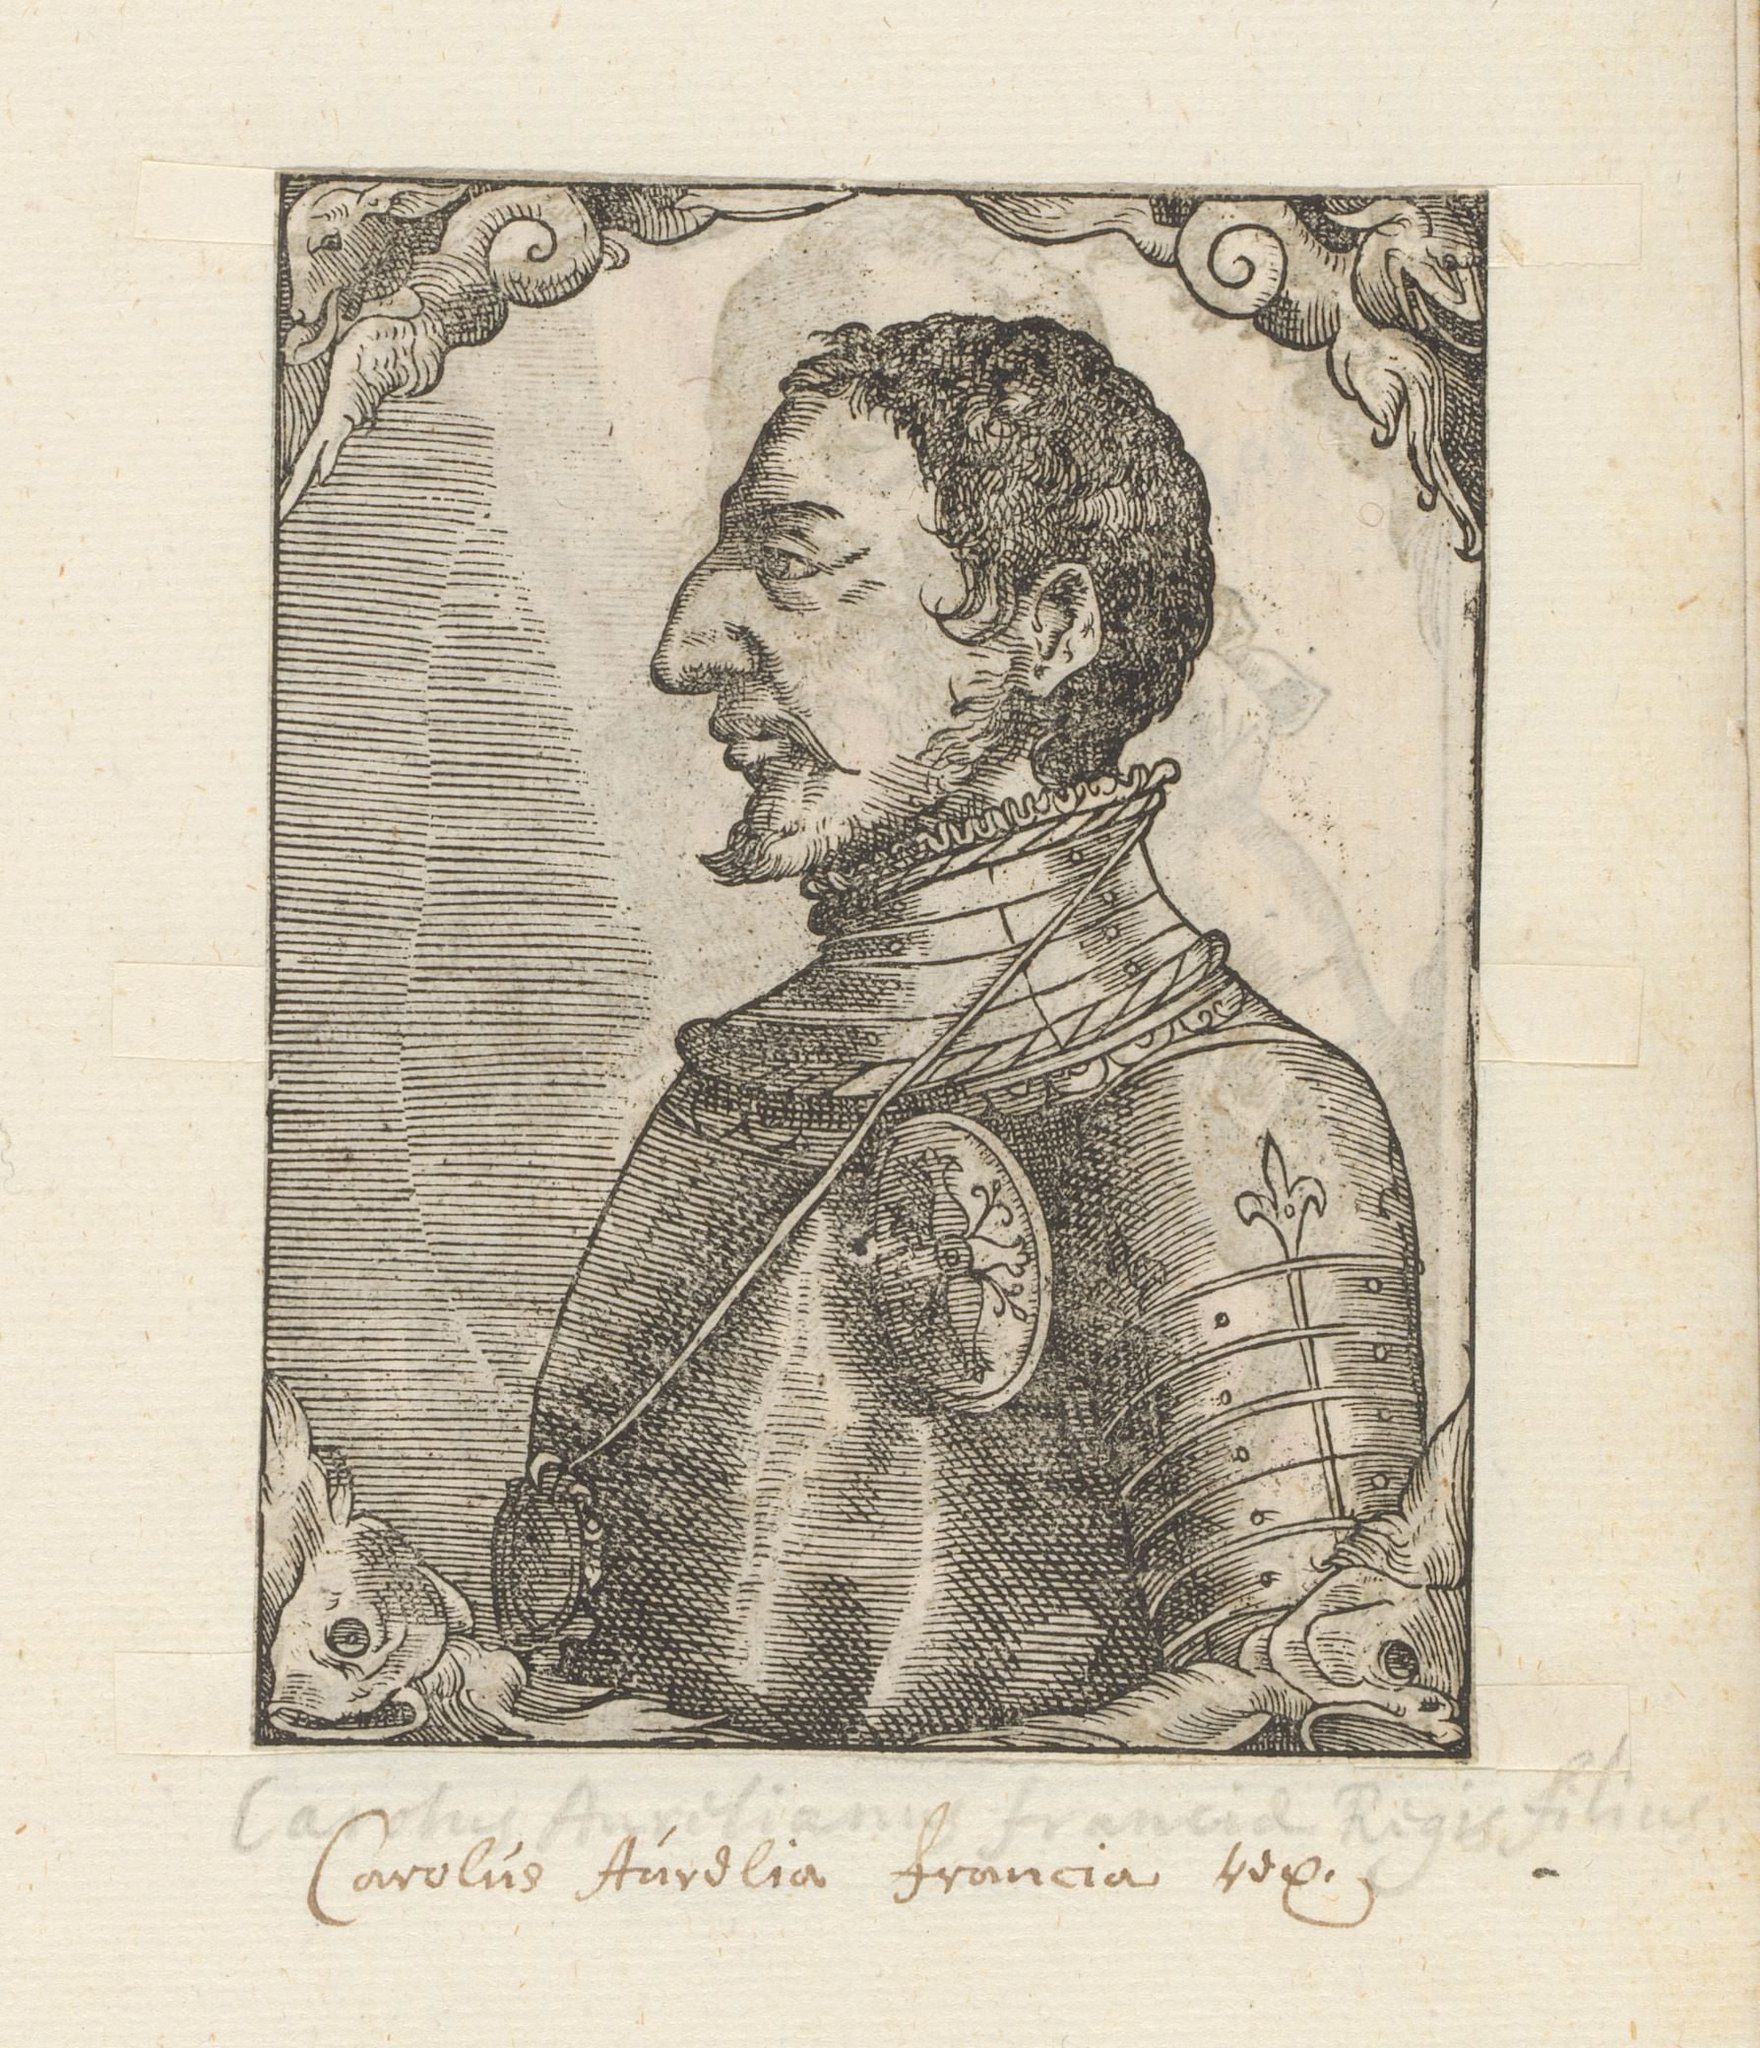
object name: album leaf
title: Portret van Karel van Angoulême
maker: Anonymous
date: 1549-1575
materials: paper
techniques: woodcut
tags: historical persons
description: Prent gebruikt in: Giovio, Paolo. Elogia Virorum bellica virtute illustrium (...). Bazel: Peter Perna, 1575.